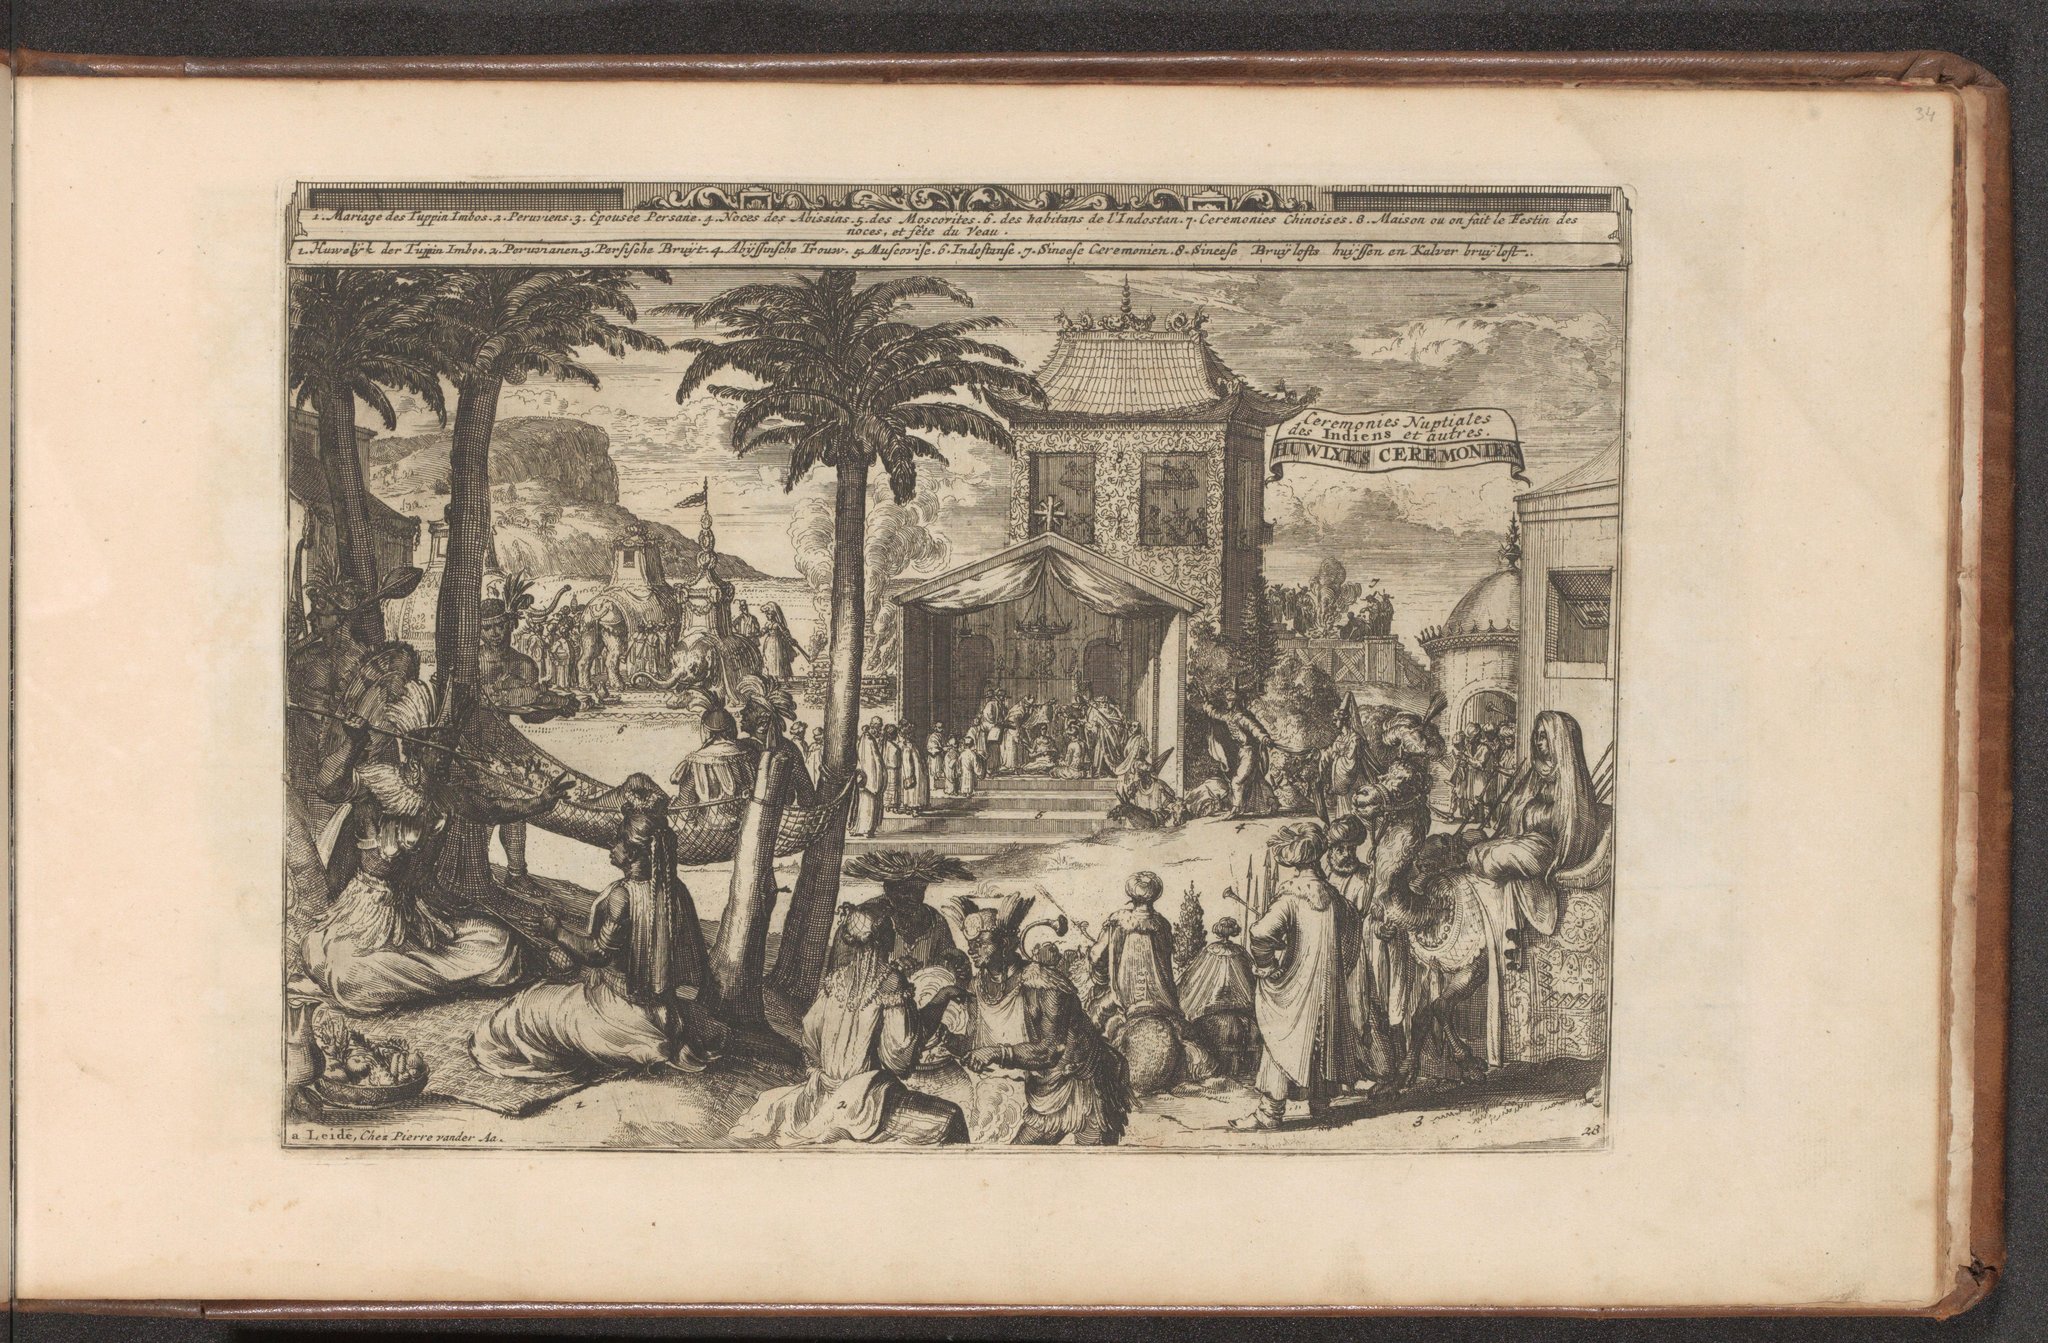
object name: print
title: Huwlyks Ceremonien / Ceremonies Nuptiales des Indiens et autres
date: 1682-1733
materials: paper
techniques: etching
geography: leiden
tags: (civil) marriage ceremonies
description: Landschap met huwelijksceremonieën van verschillende volkeren in Oost- en West-Indië. Links een slaapnet en een man die een speer op een vrouw richt. Met een legenda in het Nederlands en het Frans. De prent maakt deel uit van een album.